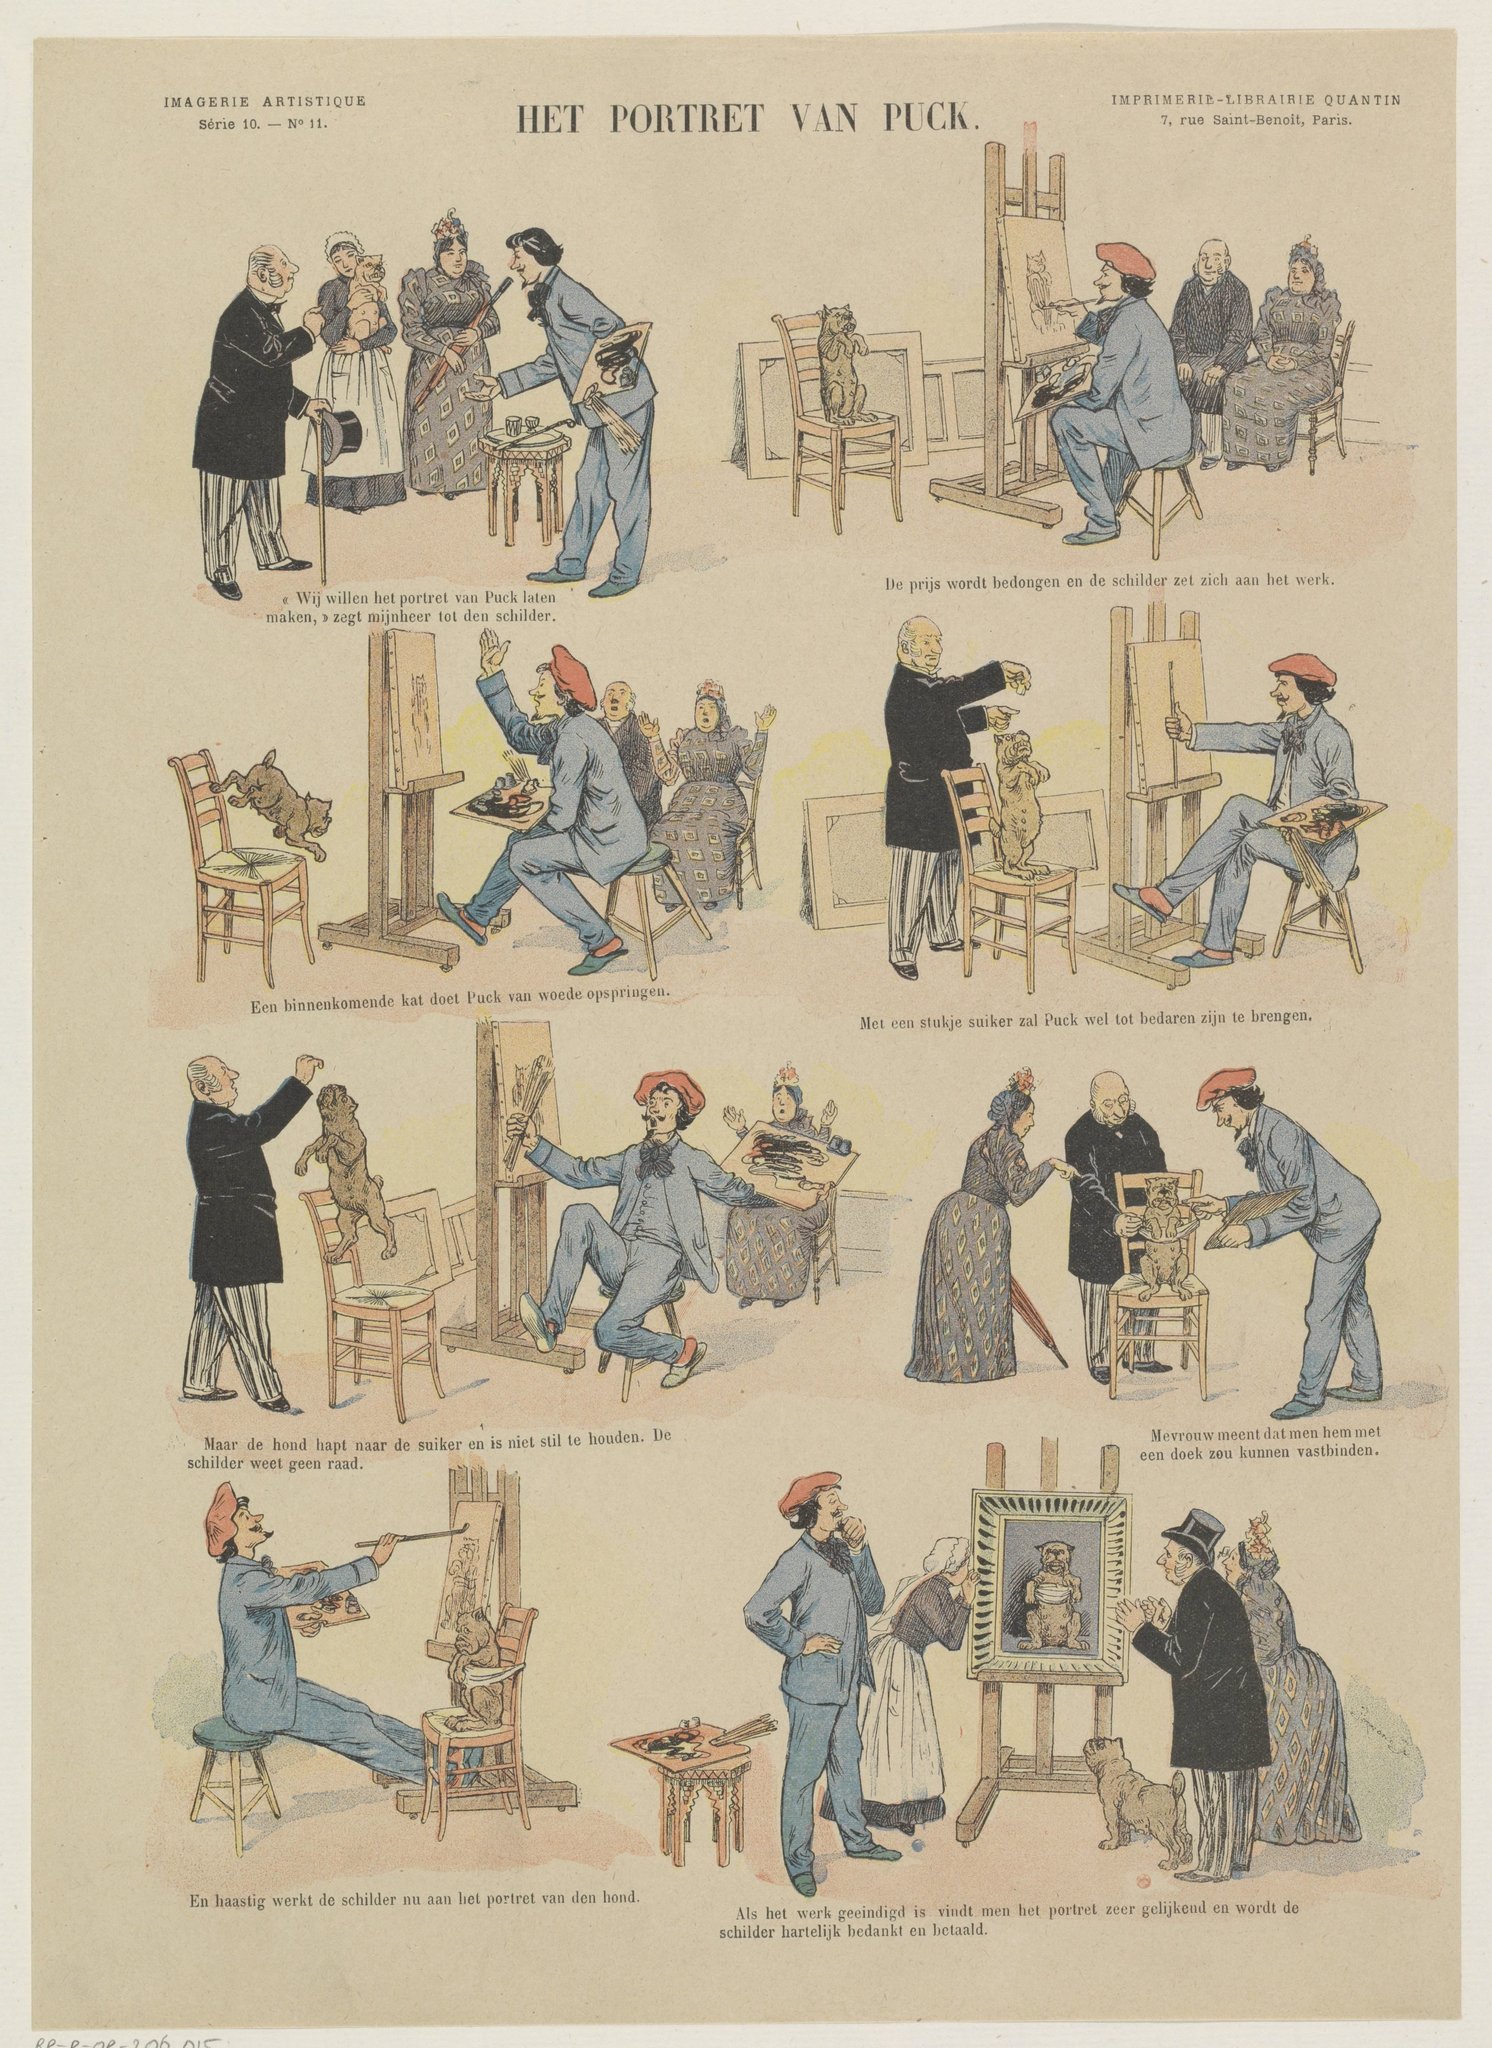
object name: print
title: Het portret van Puck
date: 1876-1890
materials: paper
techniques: lithograph, letterpress printing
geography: paris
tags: tales and fairy tales, working situations ~ painter, dog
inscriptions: collector's mark: Lugt 2760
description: Blad met 8 voorstellingen van een schilder die een portret van een hond moet schilderen. De hond wil echter niet stil blijven zitten. Onder elke afbeelding een onderschrift. Genummerd linksboven: Série 10. - No. 11.